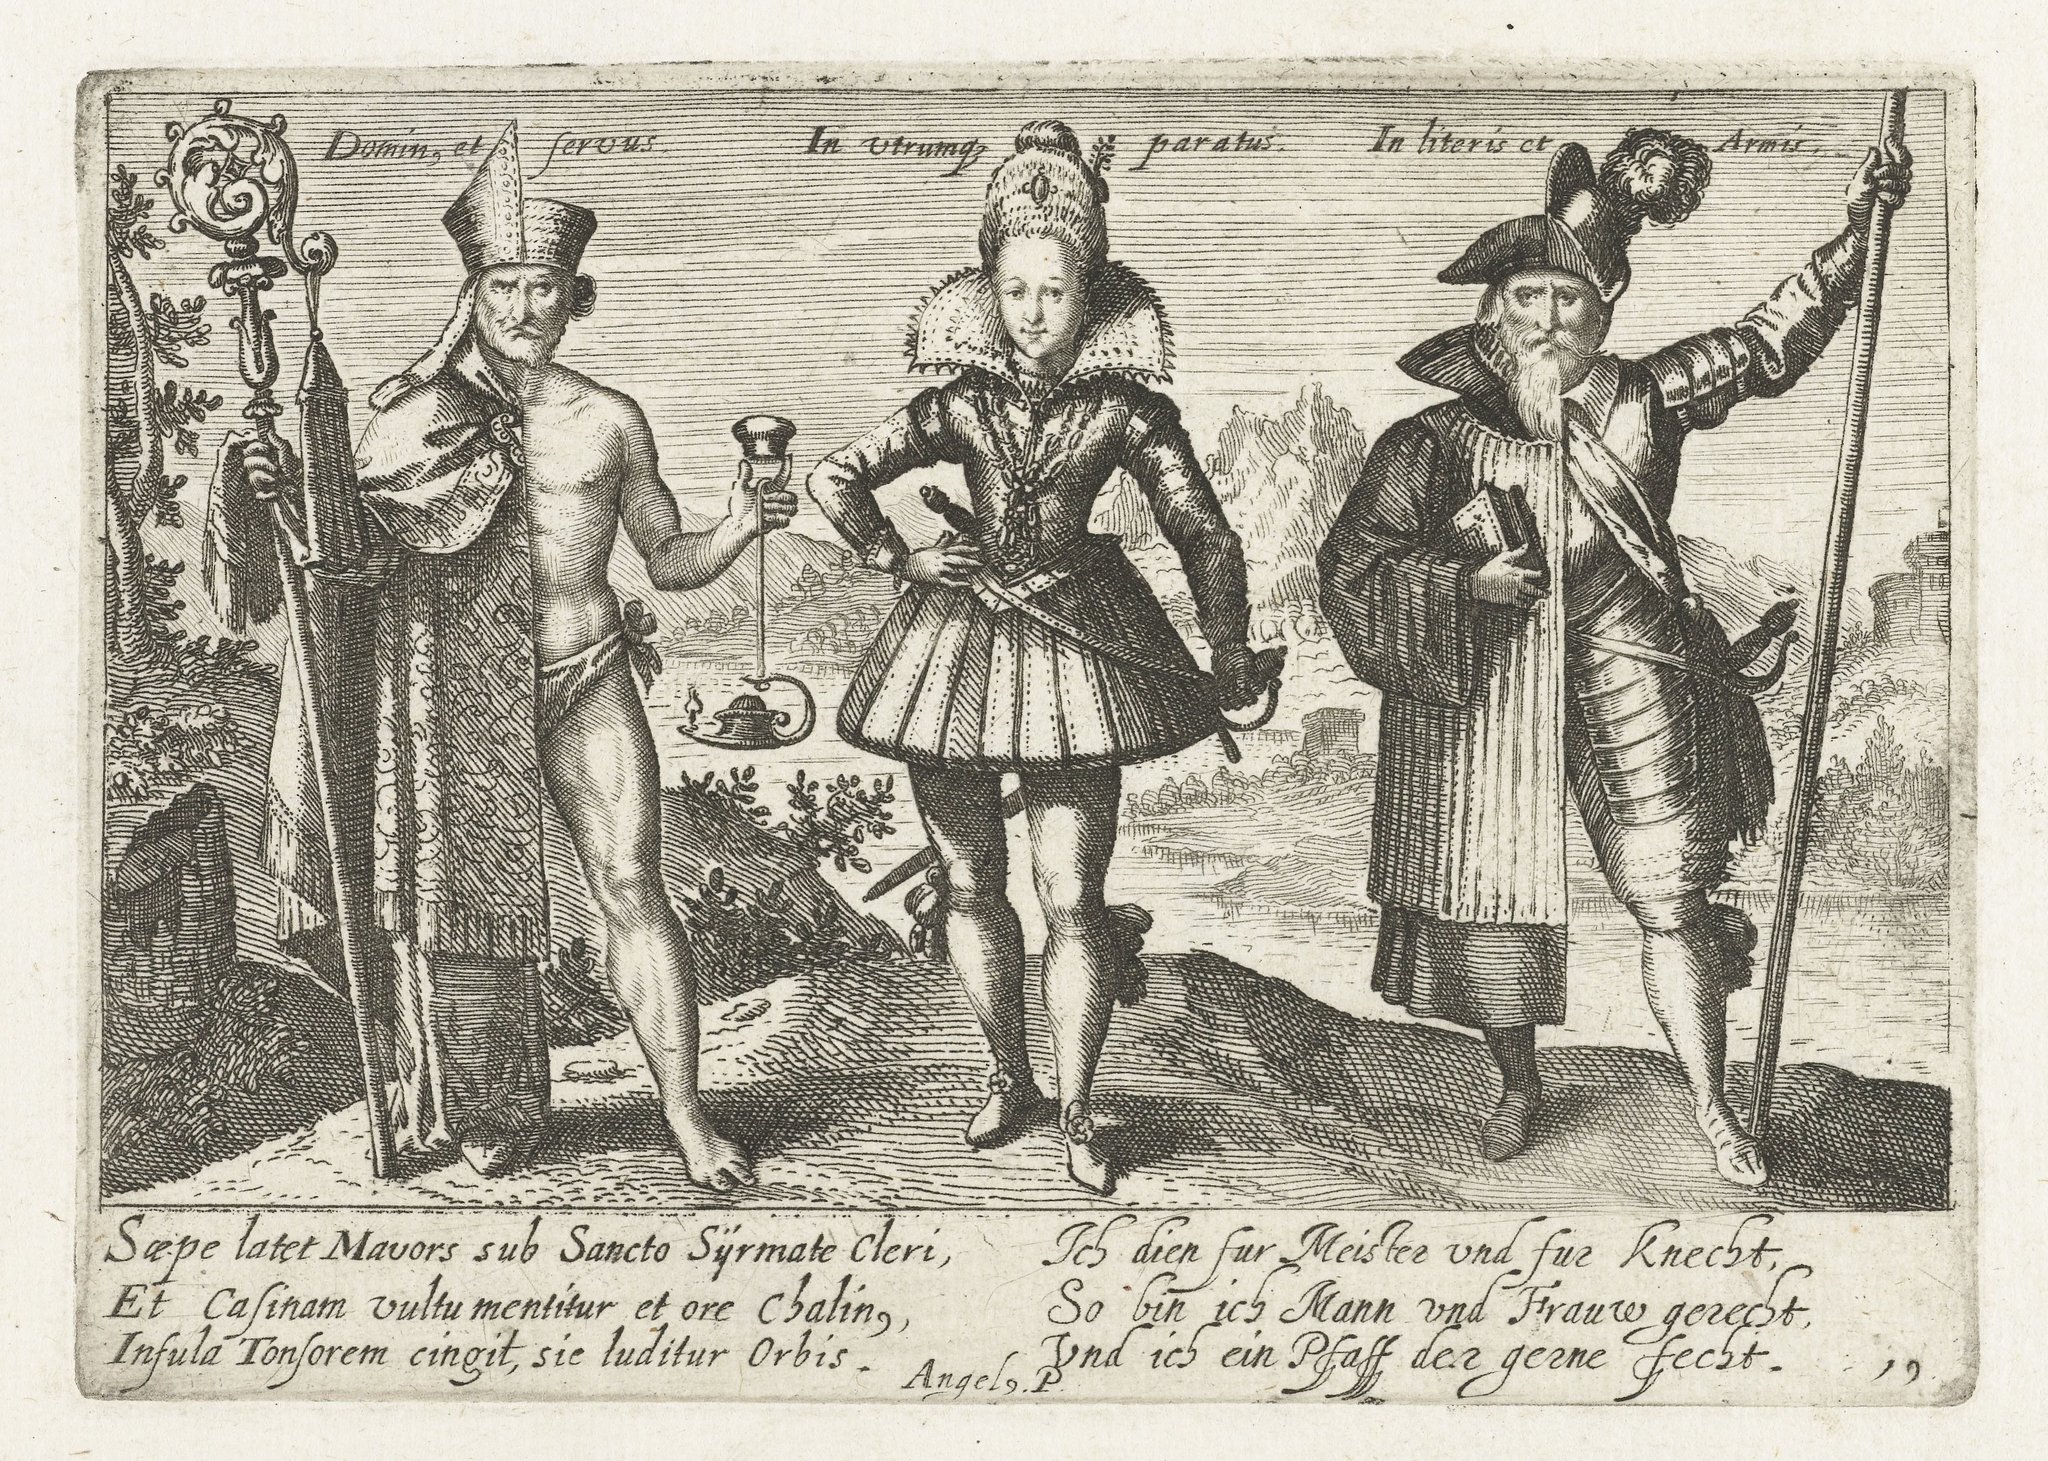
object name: print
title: Allegorie op de verschillende kanten van een karakter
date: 1608-1618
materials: paper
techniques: engraving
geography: straatsburg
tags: 'album amicorum', 'stammbuch', morality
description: Deze serie, getiteld ‘Pugillus facetiarum iconographicarum in studiosorum (…)’, bestond vermoedelijk uit 36 of meer prenten. Van deze serie zijn in ieder geval twee uitgaven bekend, uit 1608 en 1618. De prenten uit deze serie in de collectie van het Rijksmuseum (RP-P-1996-1 t/m RP-P-1996-36) zijn vermoedelijk afkomstig uit verschillende uitgaven, of uit de tweede uitgave. De inhoud van beide uitgaven verschilt, maar om de precieze inhoud van de verschillende uitgaven vast te stellen is meer onderzoek nodig. Er zijn geen volledige exemplaren van de eerste uitgave bekend. Aan de hand van de analyse van een andere serie, ‘Jeucht spieghel’,* die kopieën van ‘Pugillus’ bevat en is uitgegeven in 1610 én de aanwezige exemplaren van prenten uit ‘Pugillus’ in een inmiddels verloren album amicorum uit 1610,** kan in ieder geval van een aantal prenten gesteld worden dat ze al voorkwamen in de uitgave van 1608. Dit geldt voor RP-P-1996-1 (de titelprent), RP-P-1996-5, RP-P-1996-6, RP-P-1996-7, RP-P-1996-8, RP-P-1996-9, RP-P-1996-10, RP-P-1996-11, RP-P-1996-12, RP-P-1996-13, RP-P-1996-14, RP-P-1996-15, RP-P-1996-16, RP-P-1996-17, RP-P-1996-18, RP-P-1996-19, RP-P-1996-24, RP-P-1996-28, RP-P-1996-29, RP-P-1996-33 en RP-P-1996-35. Van één prent (RP-P-1996-31) kan vastgesteld worden dat die pas in de latere uitgave van 1618 voorkwam, omdat het kopie is van een prent uit weer een andere serie, ‘Academia sive speculum vitae scholasticae (…)’, die werd uitgegeven in 1612.*** Deze prent kwam al voor in de uitgave van 1608. Dit blijkt uit het album amicorum.** * Z.G.H.P.H.S [Zacharias Heyns]. Jeucht spieghel. S.l.s.n., 1610. Voor een gedigitaliseerd exemplaar zie: https://archive.org/details/ned-kbn-all-00000628-001/page/n9/mode/2up. ** Zie: Erman, Wilhelm en Ewald Horn. Bibliographie der deutschen Universitäten, systematisch geordnetes Verzeichnis der bis Ende 1899 gedruckten Bücher und Aufsätze über das deutsche Universitätswesen. Leipzig en Berlijn: Verlag von B.G. Teubner, 1904, dl. 1, p. 826-832, no. 17328. https://archive.org/details/bibliographieder01ermauoft/page/826/mode/2up *** Passe, Crispijn van de (I). Academia sive speculum vitae scholasticae (…). Arnhem: Johannes Janssonius [Jan Jansz.], 1612. Voor een gedigitaliseerd exemplaar zie: http://gallica.bnf.fr/ark:/12148/btv1b55005974h.